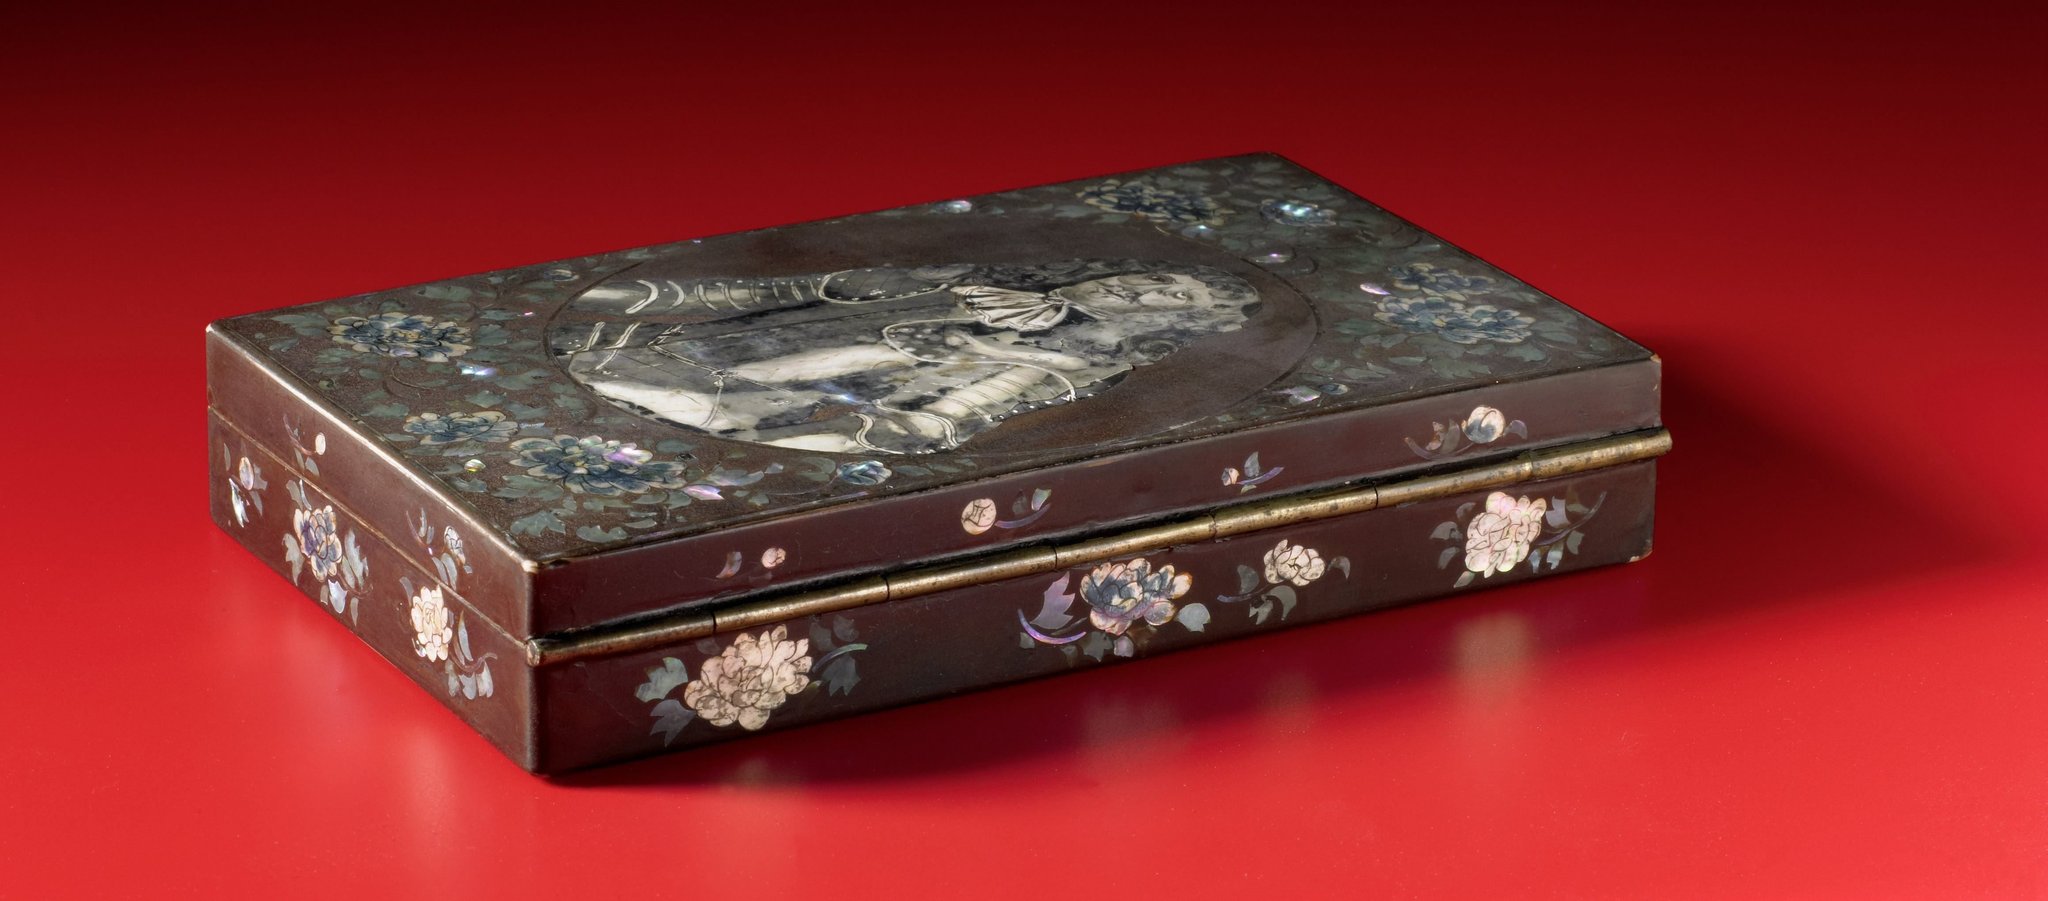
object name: box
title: Doosje Carel Rabenhaupt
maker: Anonymous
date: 1820-1840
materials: copper, lacquer, mother of pearl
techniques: inlay, lacquer, sawing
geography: japan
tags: historical persons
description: Box with a portrait of Rabenhaupt. Japanese lacquer on copper, late 17th century. Karel von Rabenhaupt (1602-1675) came to the Republic in 1622 with the Count of Mansfeld's army. As an officer in the States army, in 1672 he successfully defended Groningen, while besieged by the troops of Bernhard van Galen of Münster. After the defence of Groningen, Rabenhaupt went on to capture Coevorden.